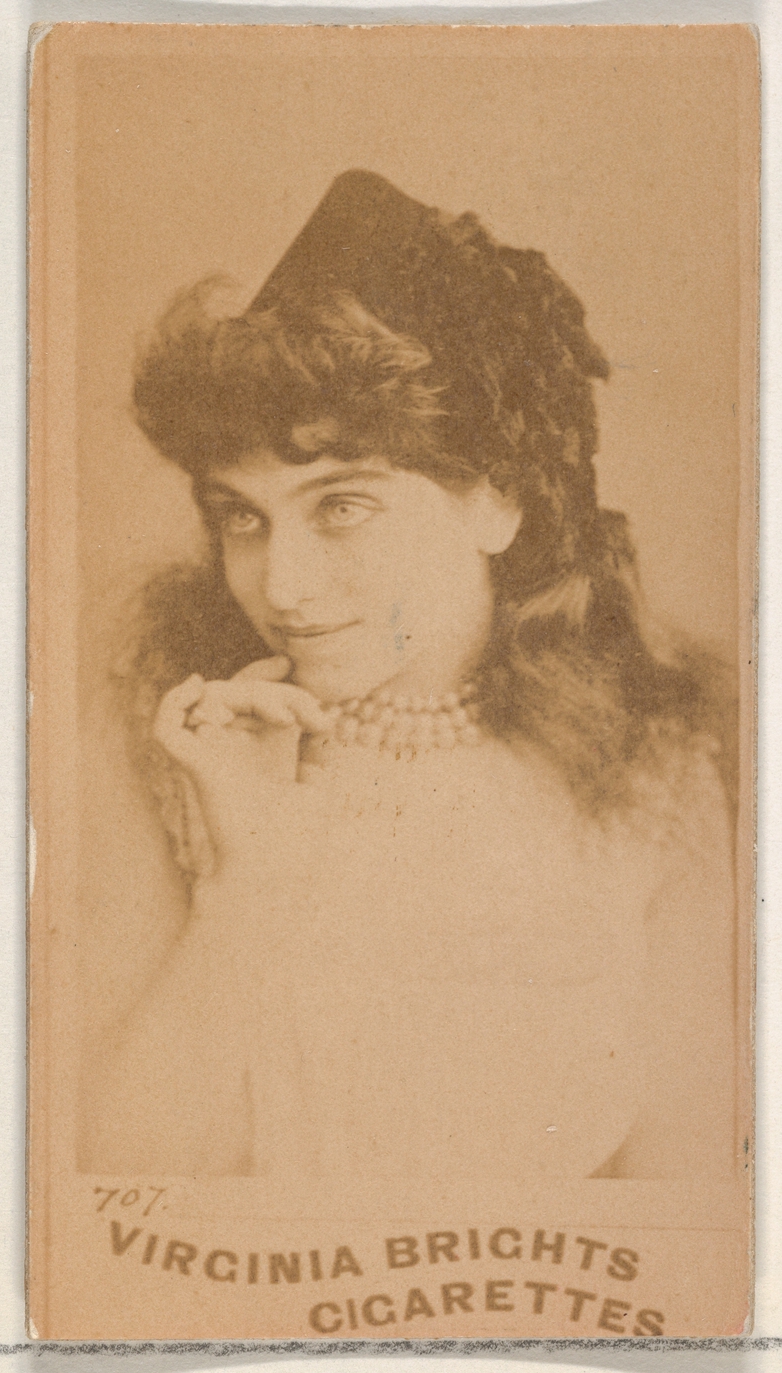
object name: photograph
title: Card 707, from the Actors and Actresses series (N45, Type 5) for Virginia Brights Cigarettes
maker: allen & ginter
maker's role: publisher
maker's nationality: american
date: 1888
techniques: albumen silver print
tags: portraits,women,actresses